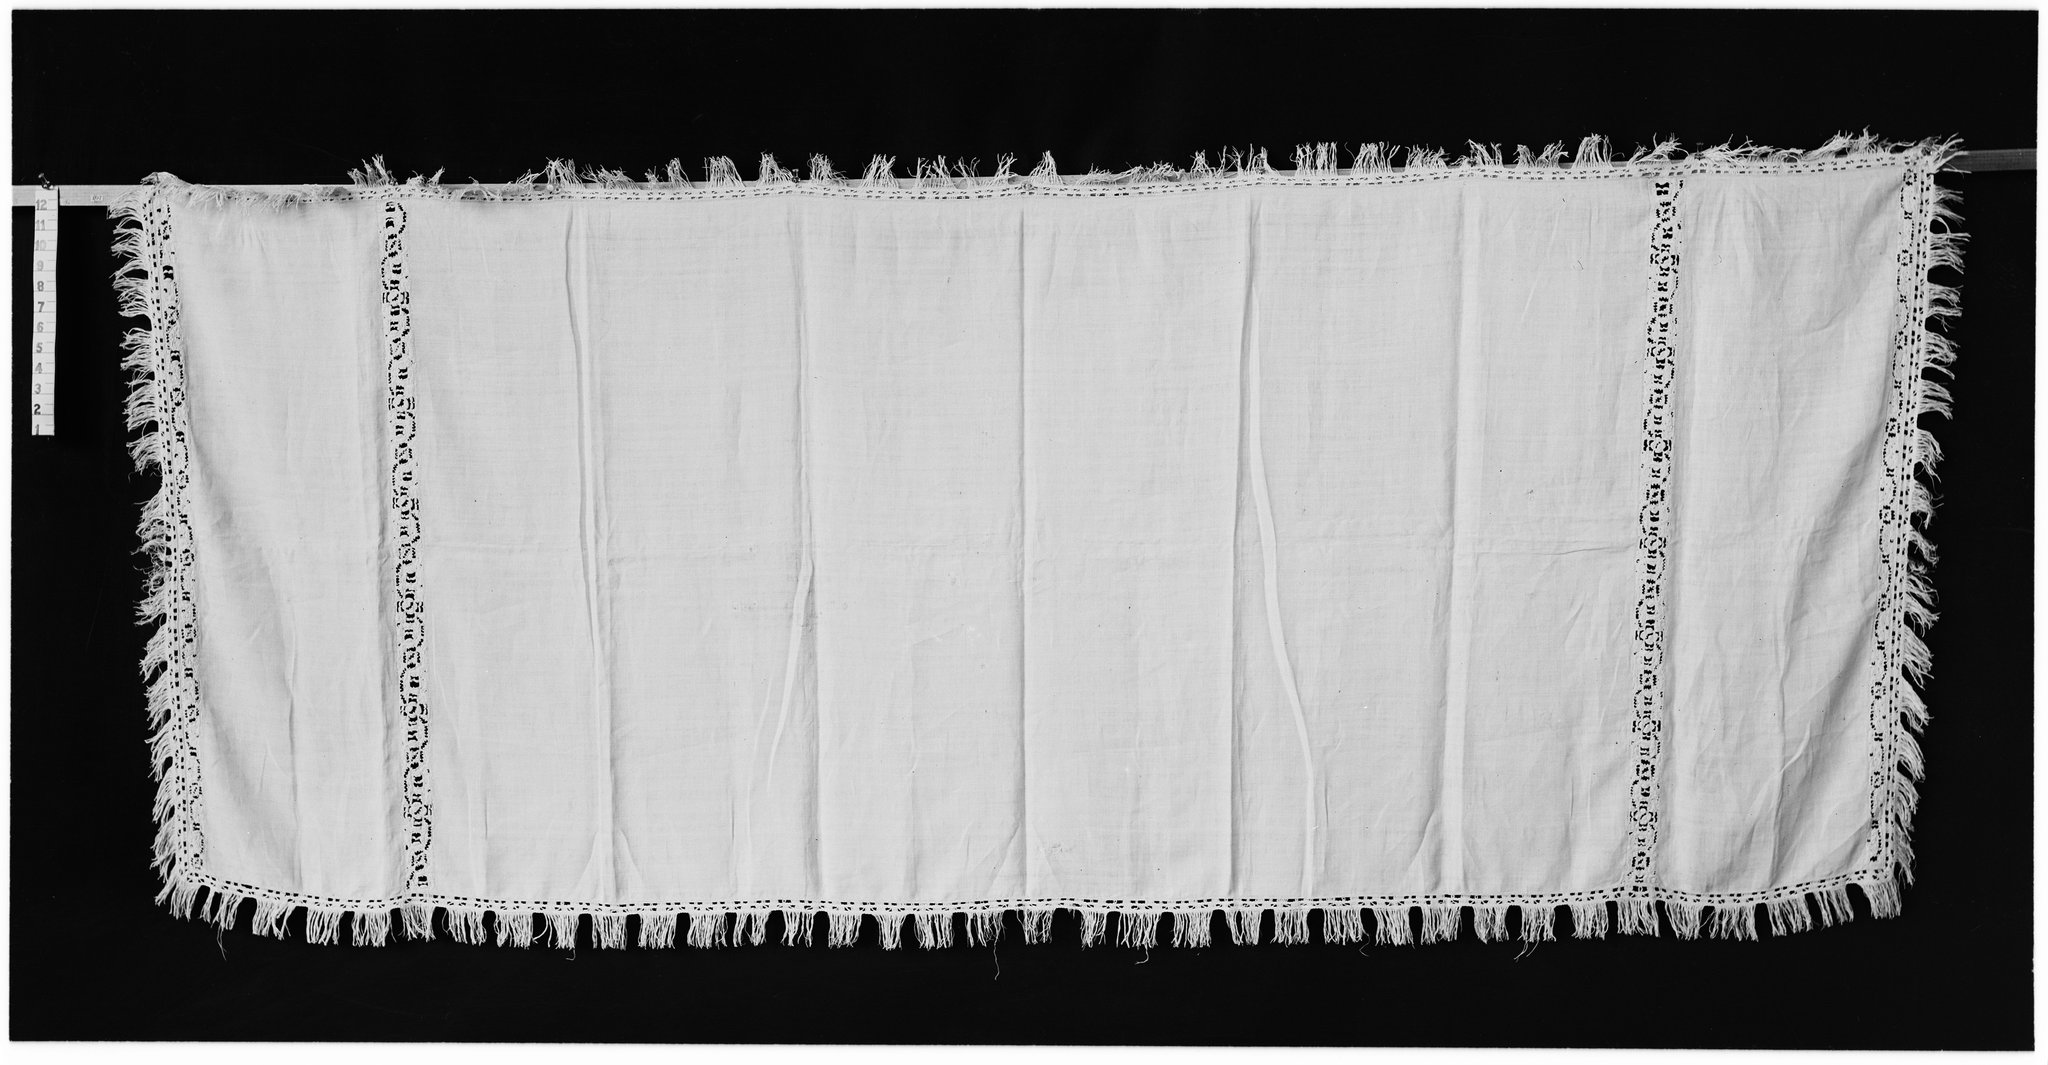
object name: cover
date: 1567-1600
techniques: embroidery